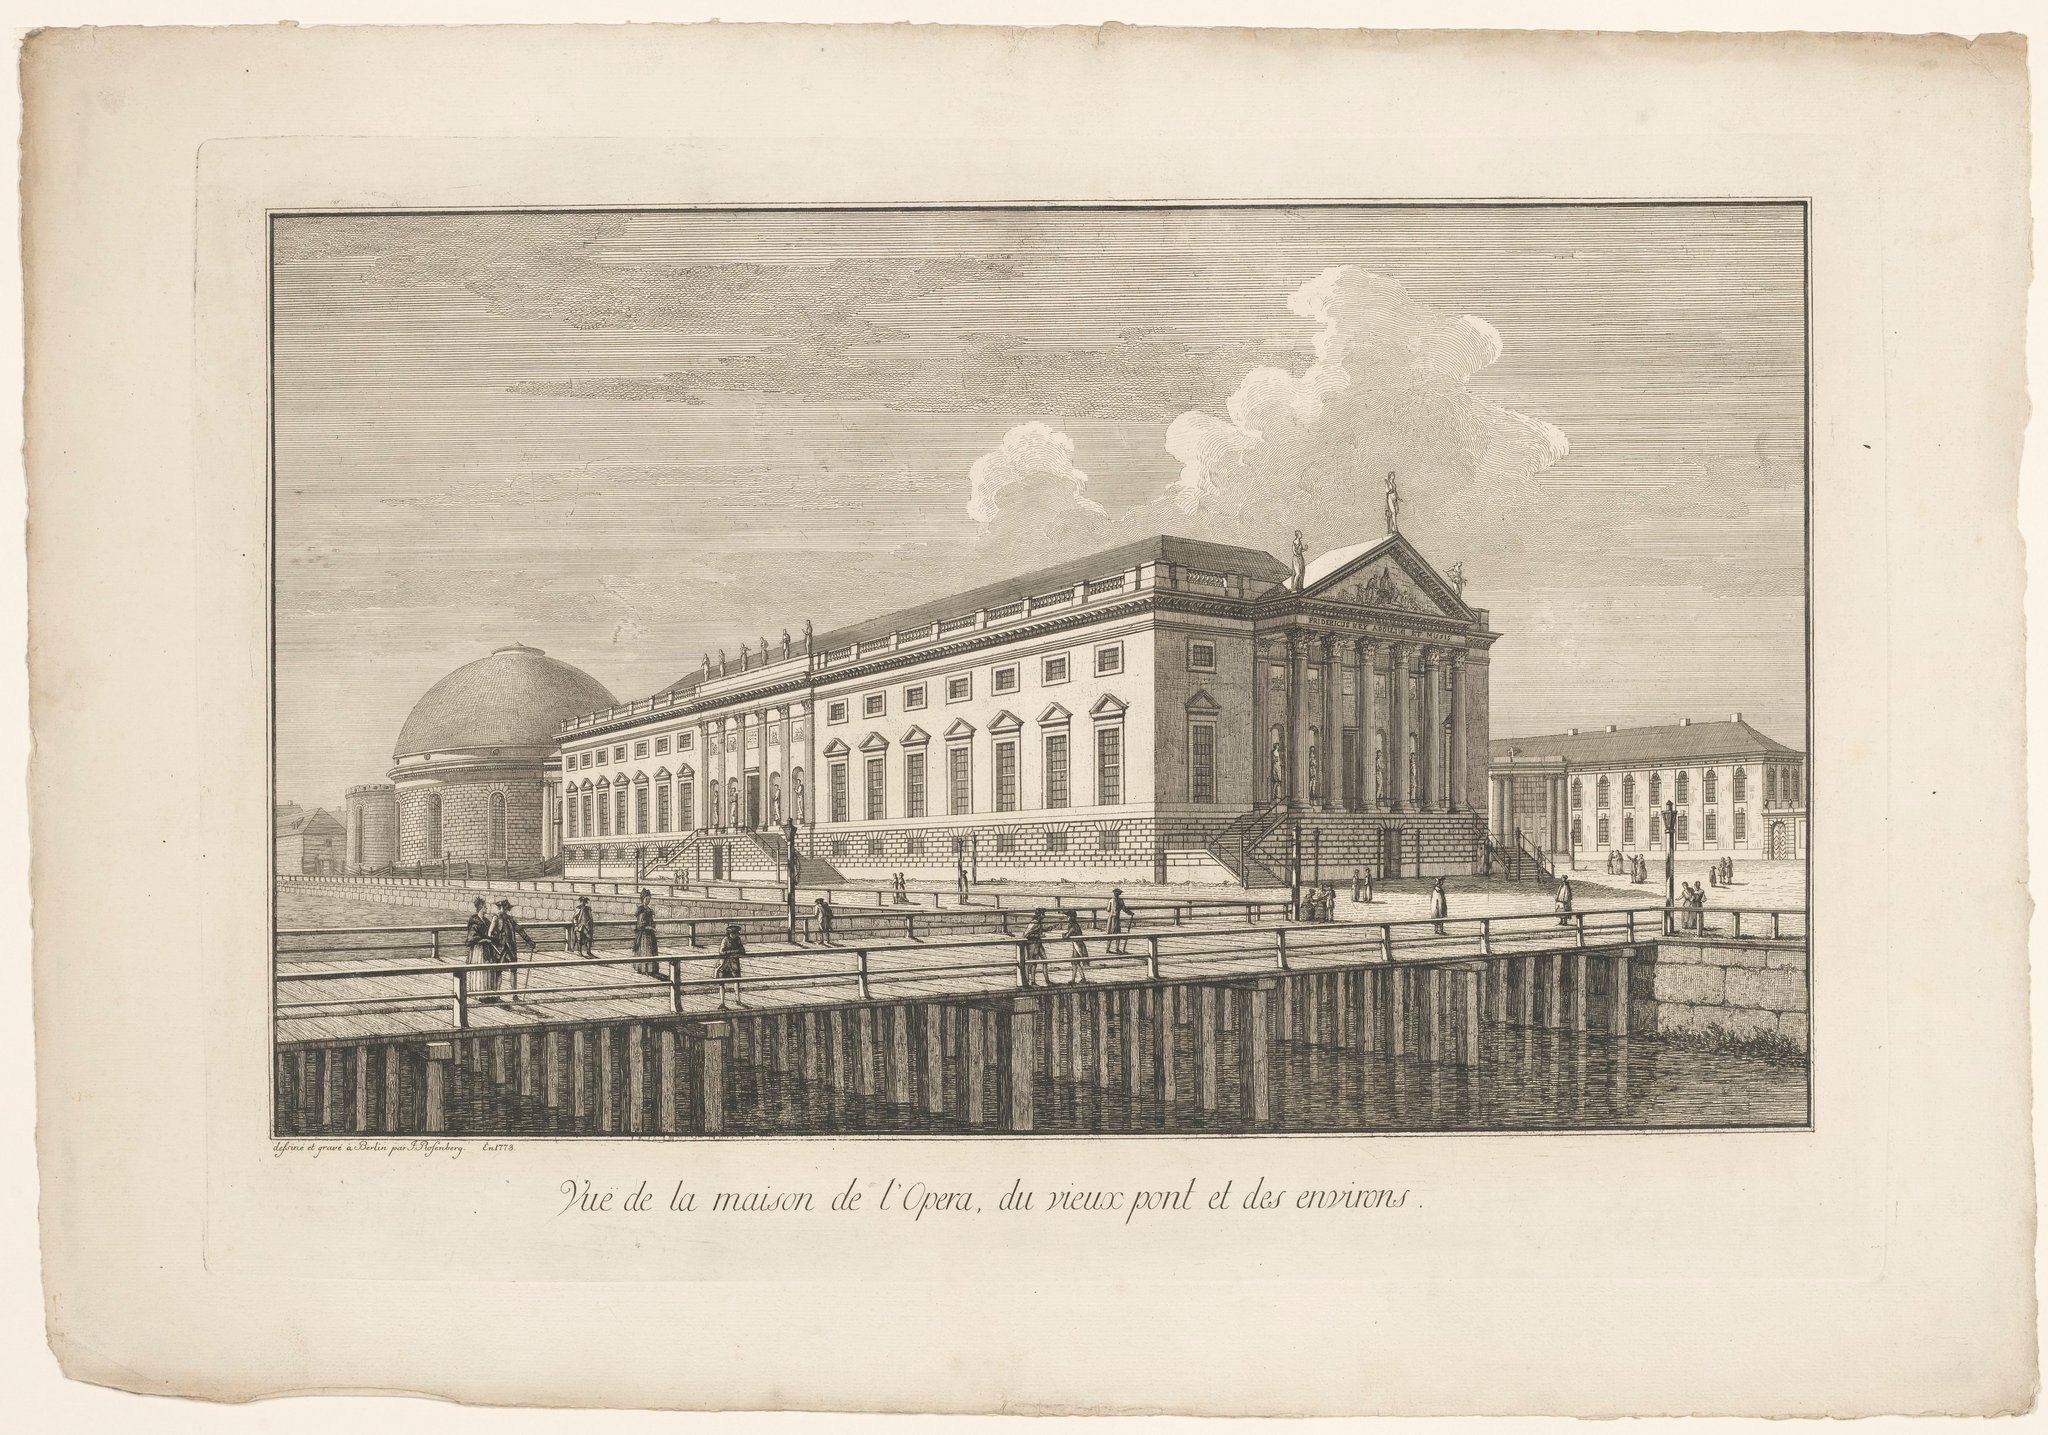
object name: print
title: Gezicht op de Staatsoper Unter den Linden in Berlijn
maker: johann georg rosenberg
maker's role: print maker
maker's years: 1739-1808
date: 1773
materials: paper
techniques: etching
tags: opera house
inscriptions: collector's mark